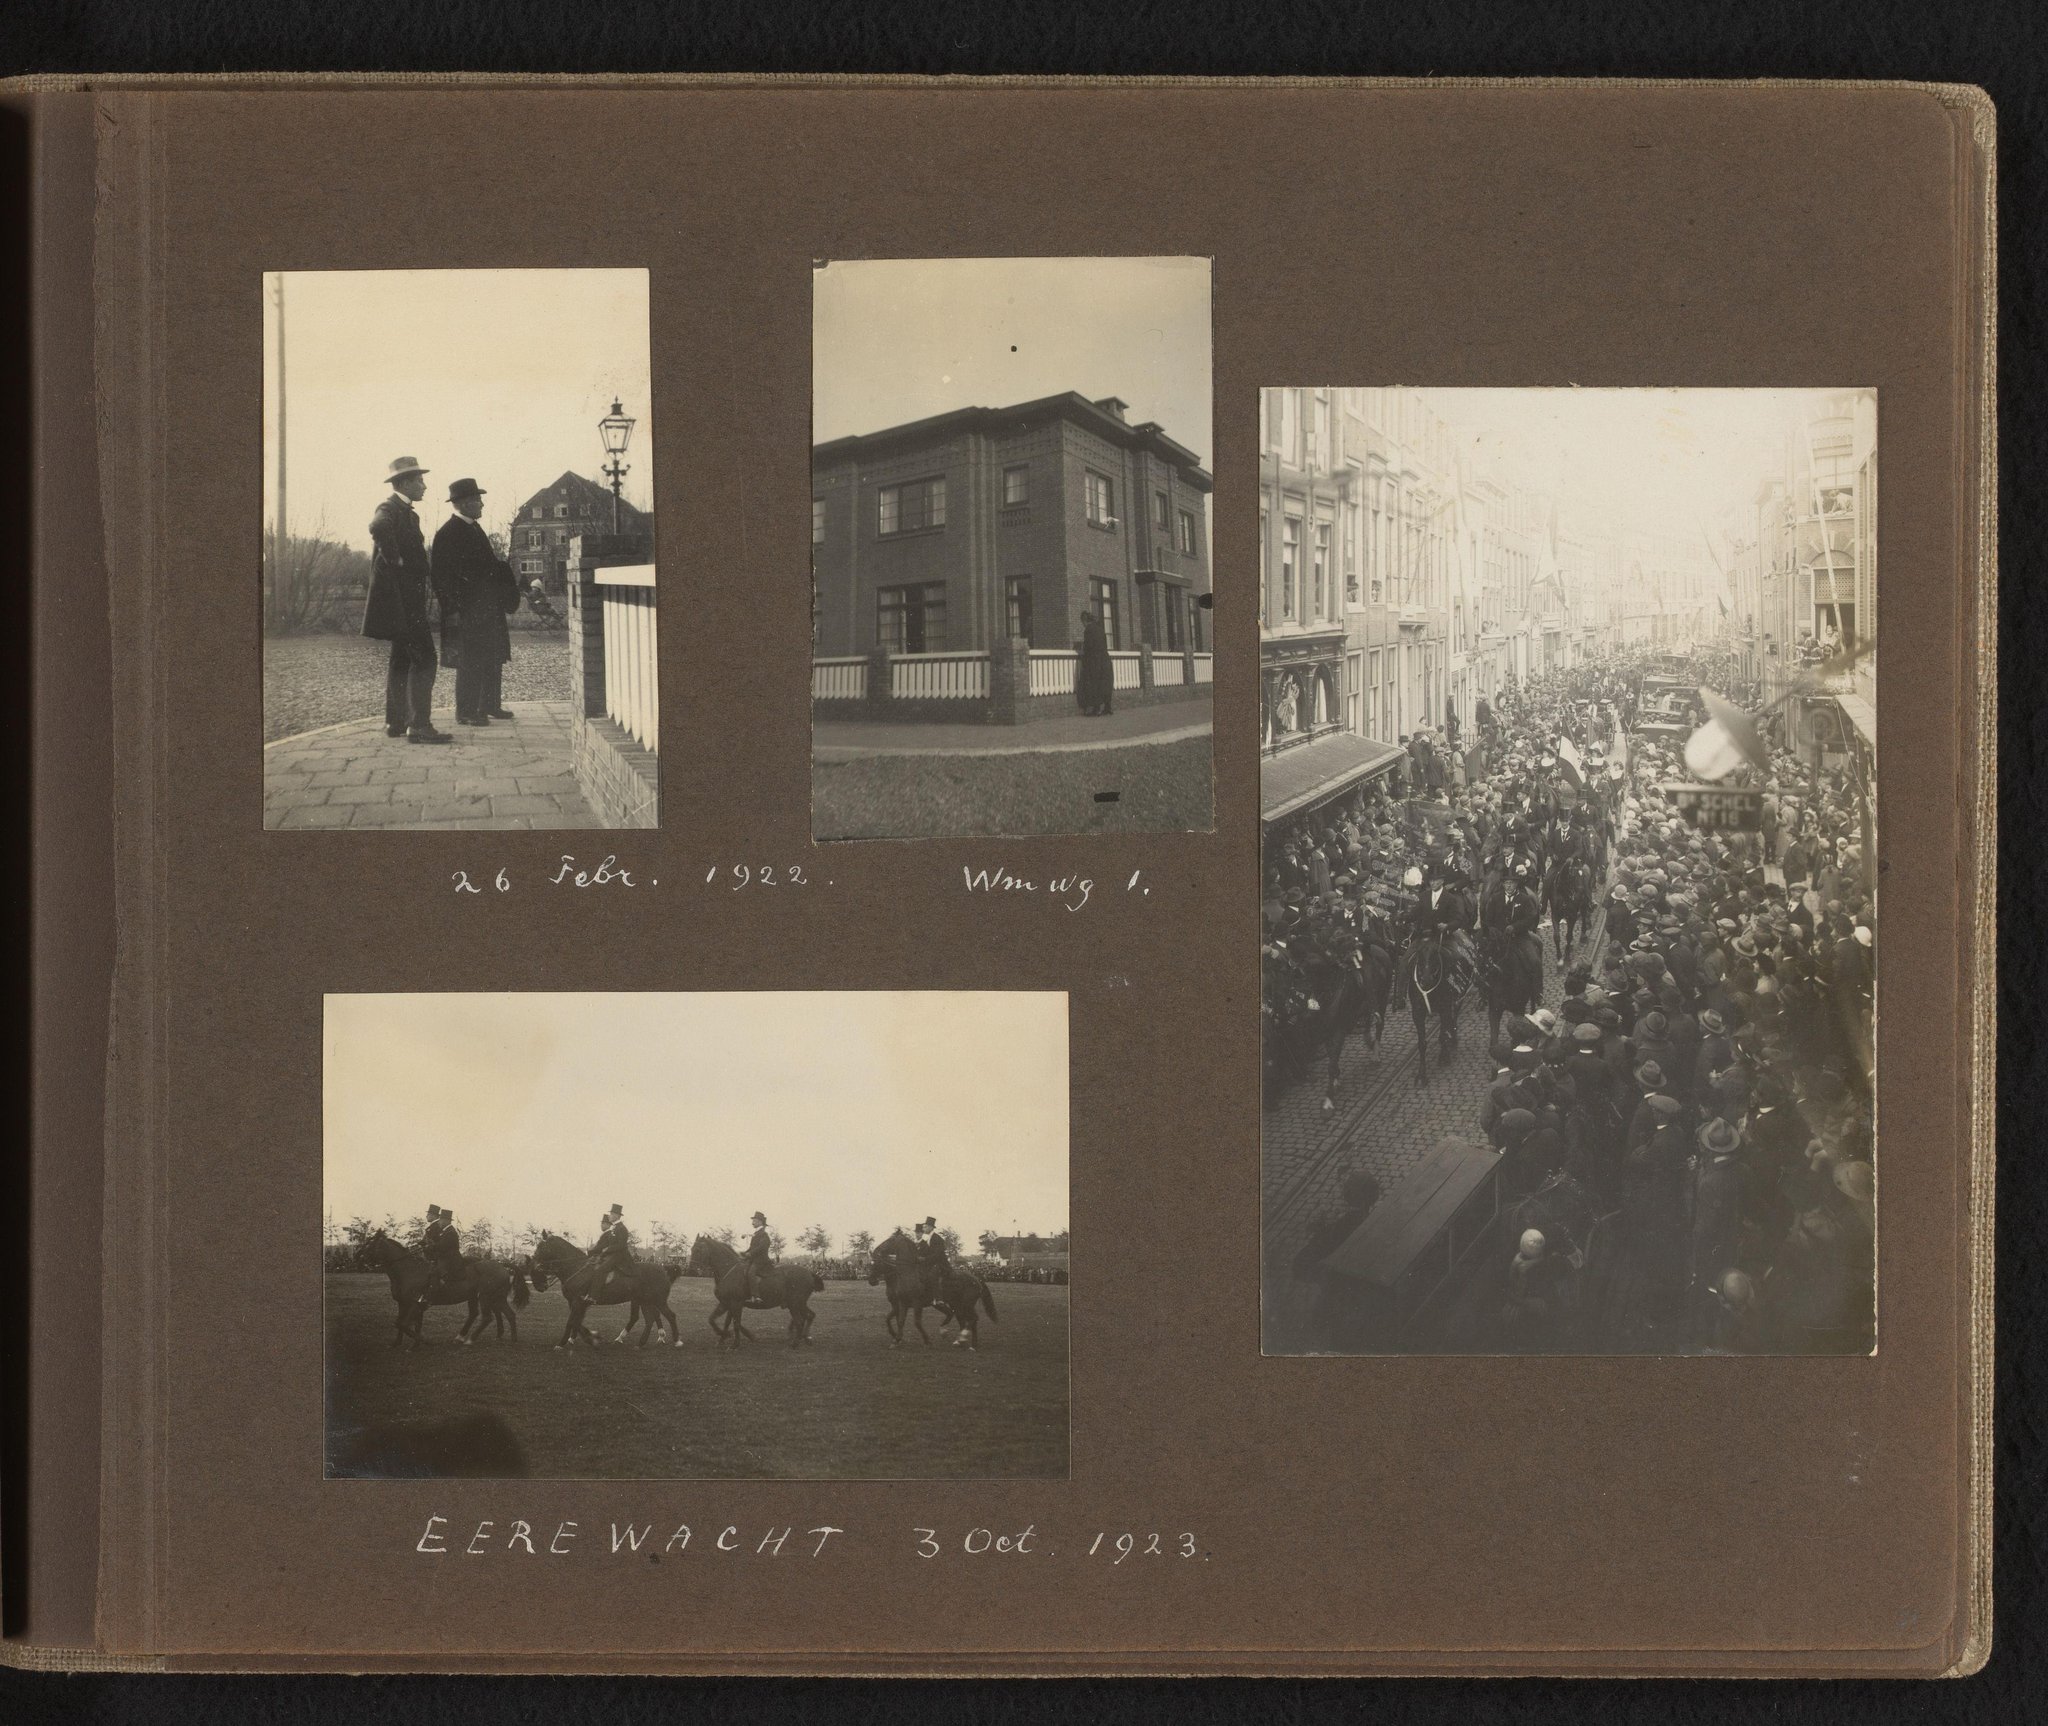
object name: photograph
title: Twee mannen en een vrouw bij een woning, mogelijk Oegstgeest, en een parade met erewacht ter gelegenheid van het 3 oktoberfeest, op een veld en in de Breestraat, Leiden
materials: paper, cardboard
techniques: gelatin silver print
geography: netherlands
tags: military parade, pageant, horse, façade (of house or building)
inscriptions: inscription: ‘26 Febr. 1922. Wm wg 1.’, inscription: ‘EEREWACHT 3 Oct. 1923’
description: Deze foto's maken deel uit van een album.